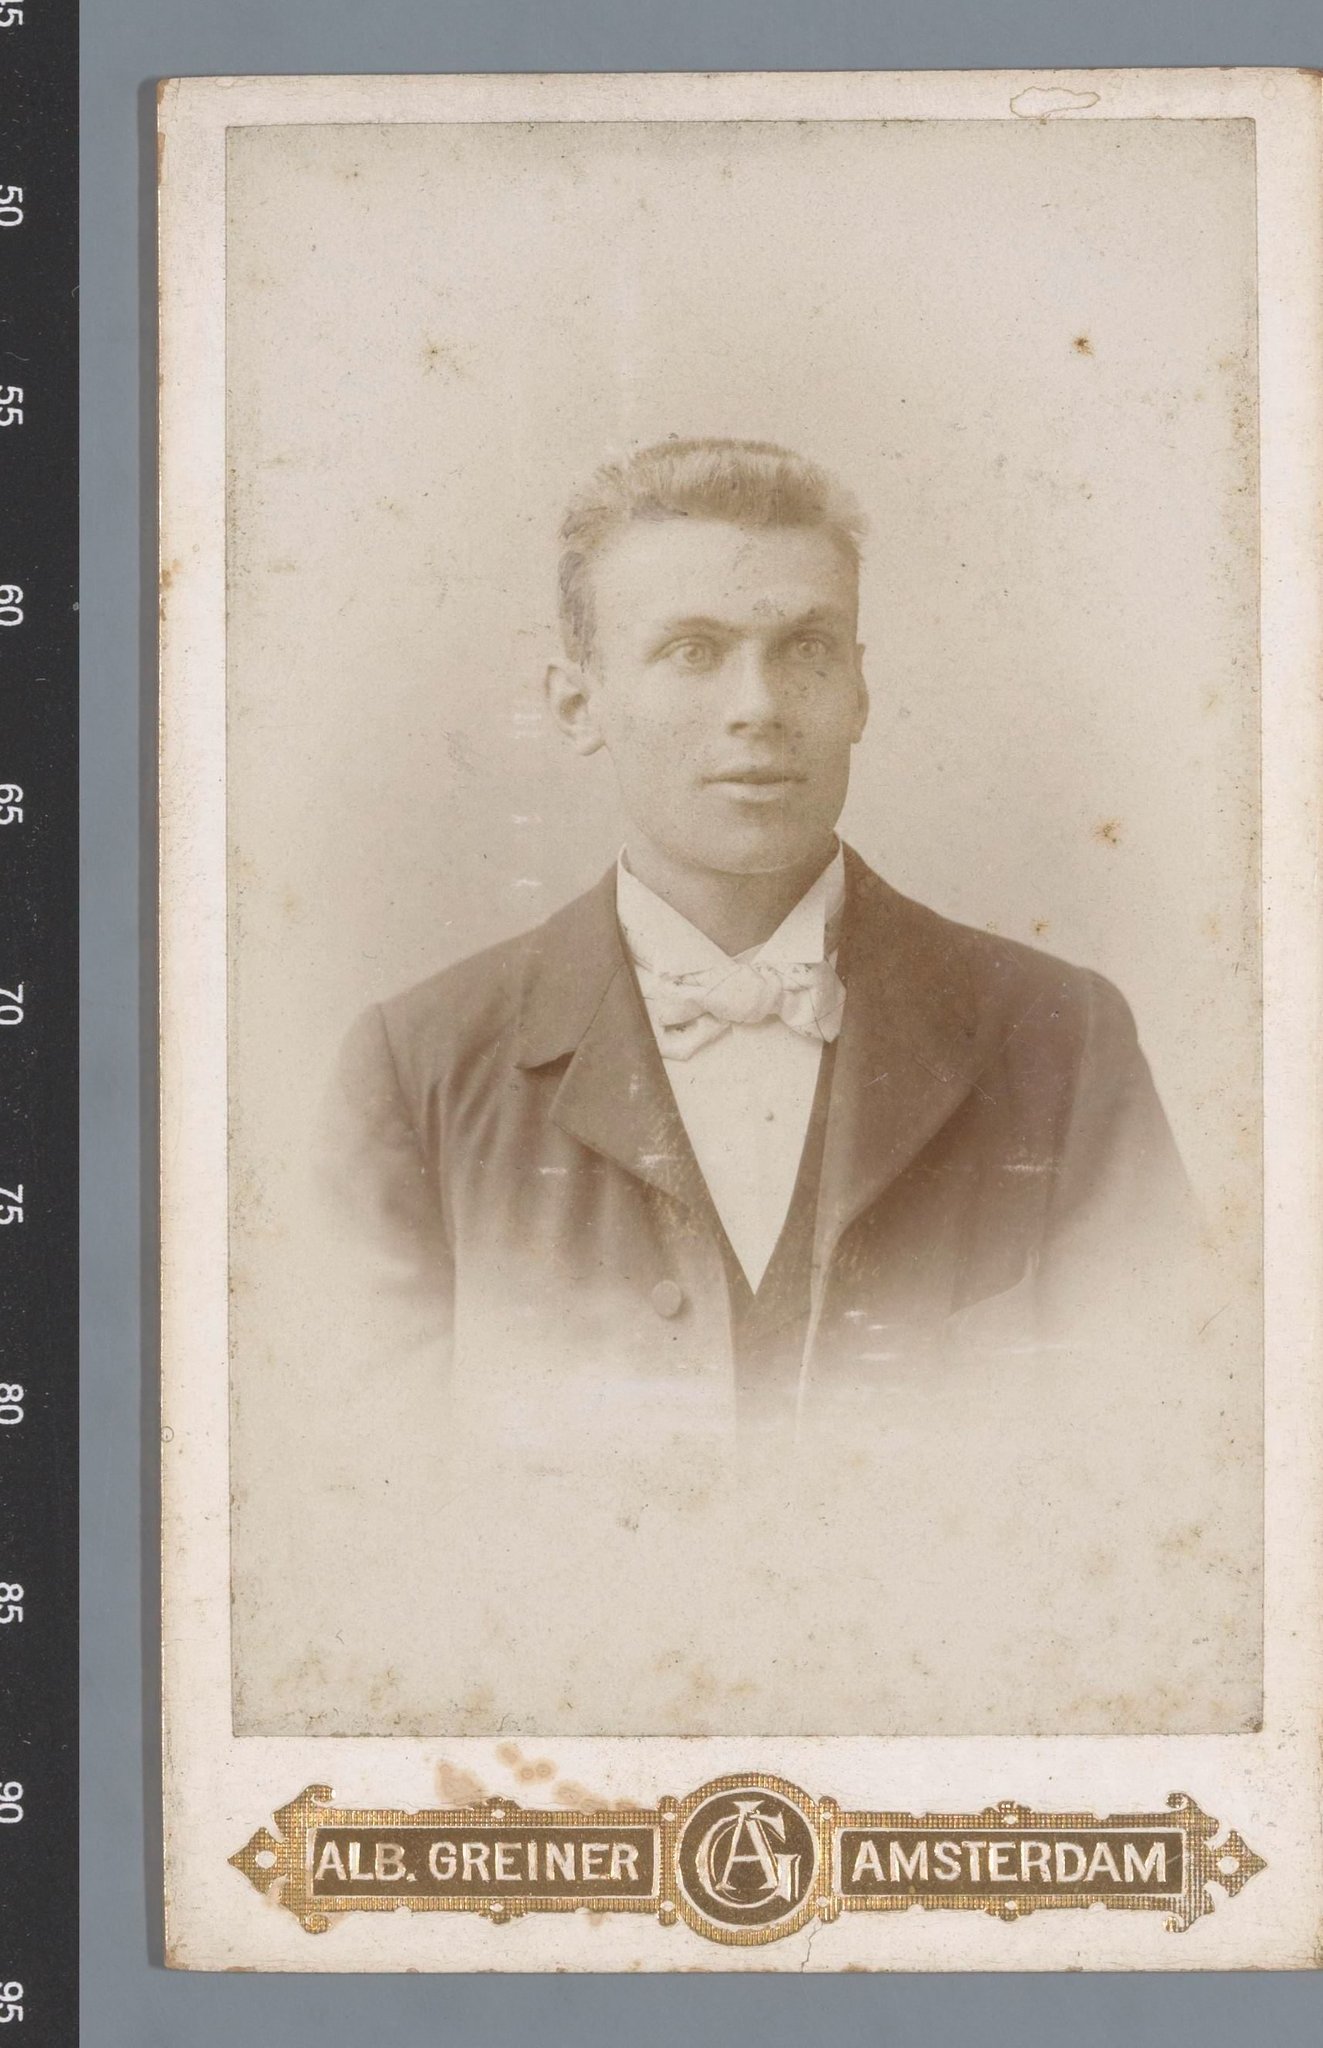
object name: photograph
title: Portret van een onbekende man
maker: albert greiner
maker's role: fotograaf, fotostudio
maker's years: 1833-1890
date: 1861-1890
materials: cardboard, paper, photographic support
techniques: collodion silver print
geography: amsterdam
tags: adult man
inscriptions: name: ‘Albert Greiner Amsterdam Nieuwendijk 89. Specialiteit in Vergrootingen’, name: ‘Ferd. Beyrich, Berlin’, name: ‘Alb. Greiner Amsterdam’, number: ‘411.’